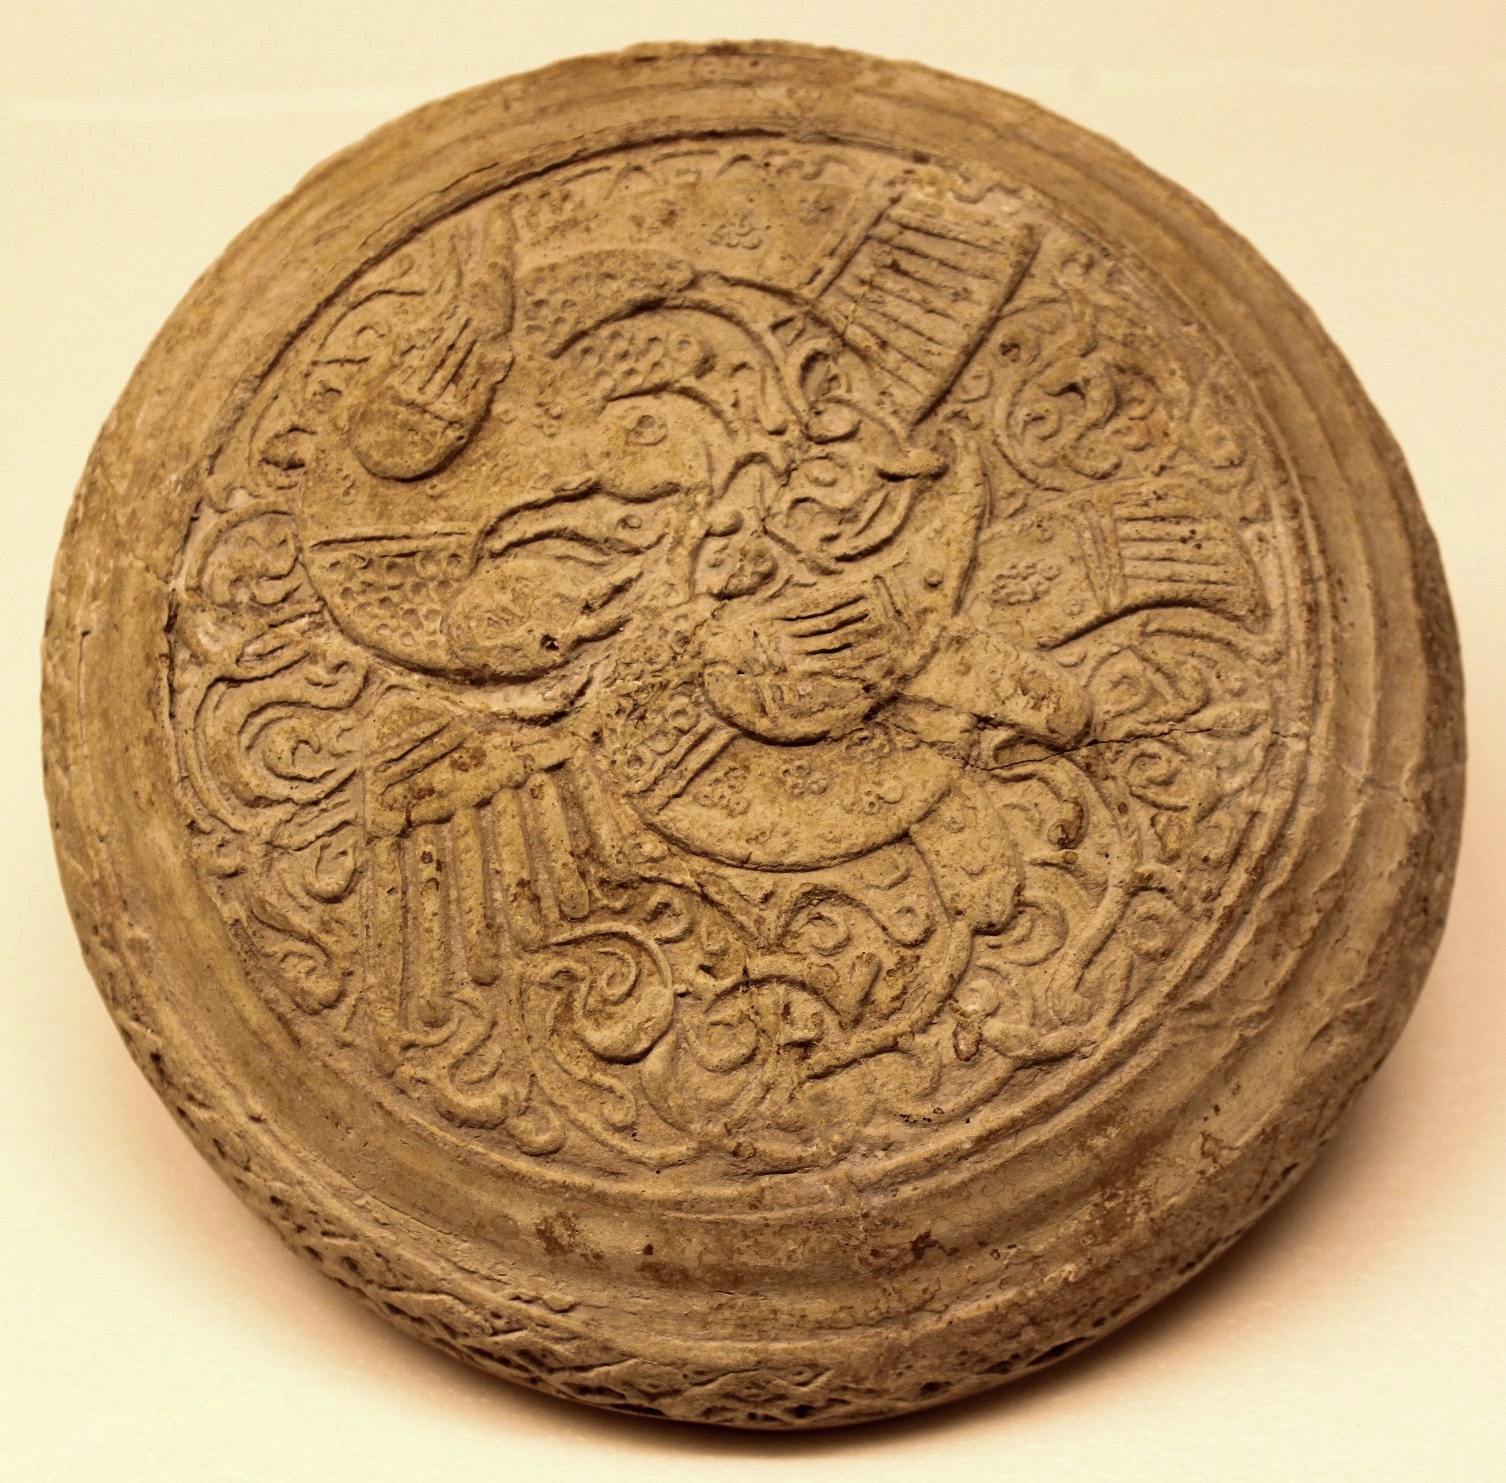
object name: lid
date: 1101-1300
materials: earthenware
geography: syria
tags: birds